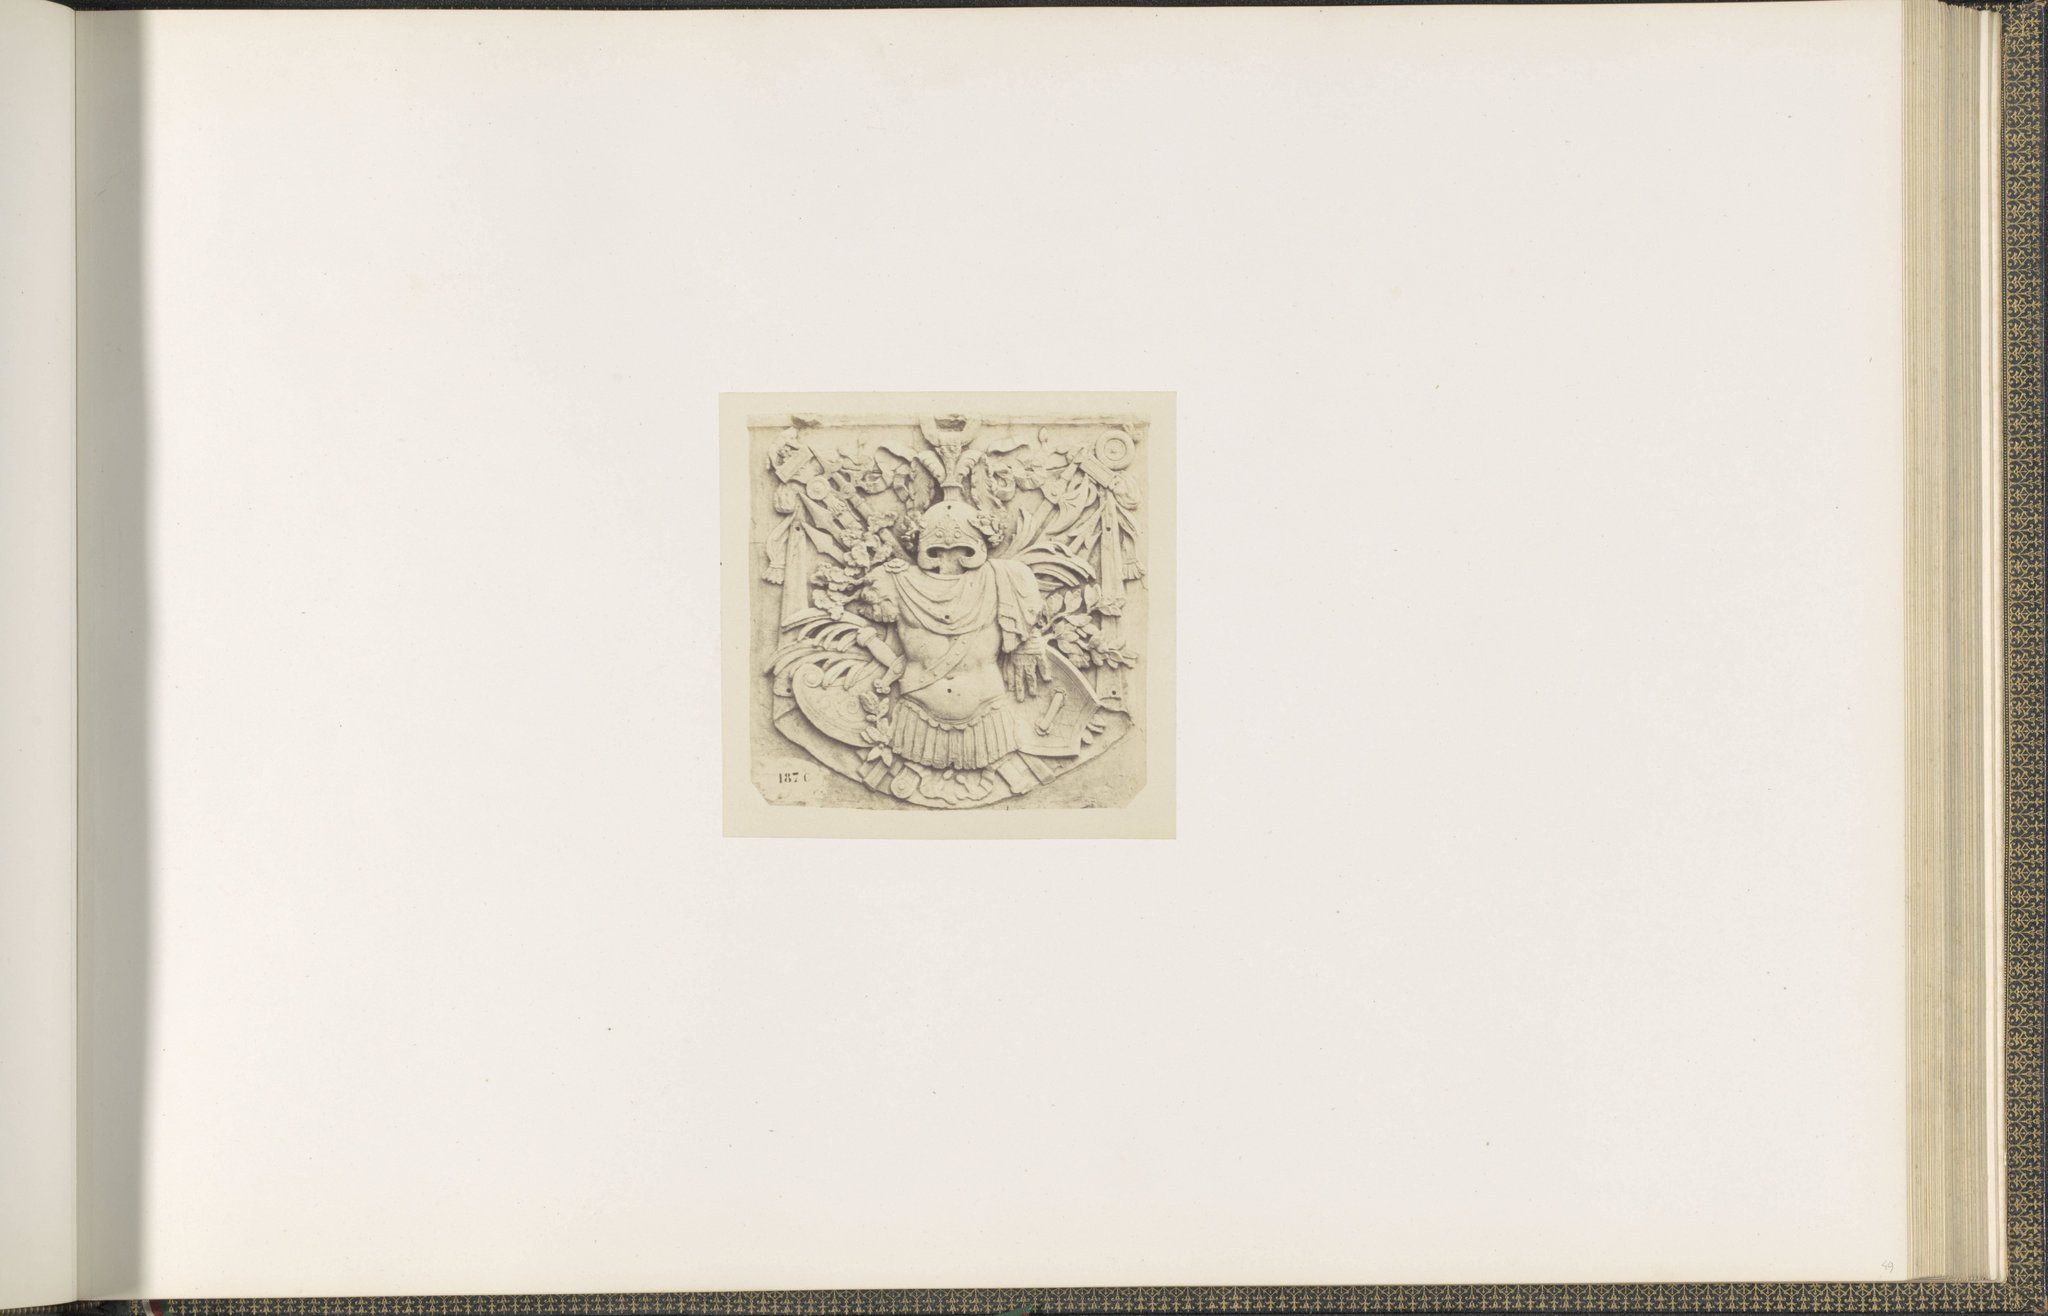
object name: photograph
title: Gipsmodel voor een wapenschild op het Palais du Louvre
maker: édouard denis baldus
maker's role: fotograaf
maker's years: 1813-1889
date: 1855-1857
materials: paper, photographic support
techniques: salted paper print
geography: paris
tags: coat of arms (as symbol of the state, etc.), permanent exhibition, museum, paris, tuileries palace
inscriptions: number: ‘187C’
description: Onderdeel van Réunion des Tuileries au Louvre 1852-1857, album 4.